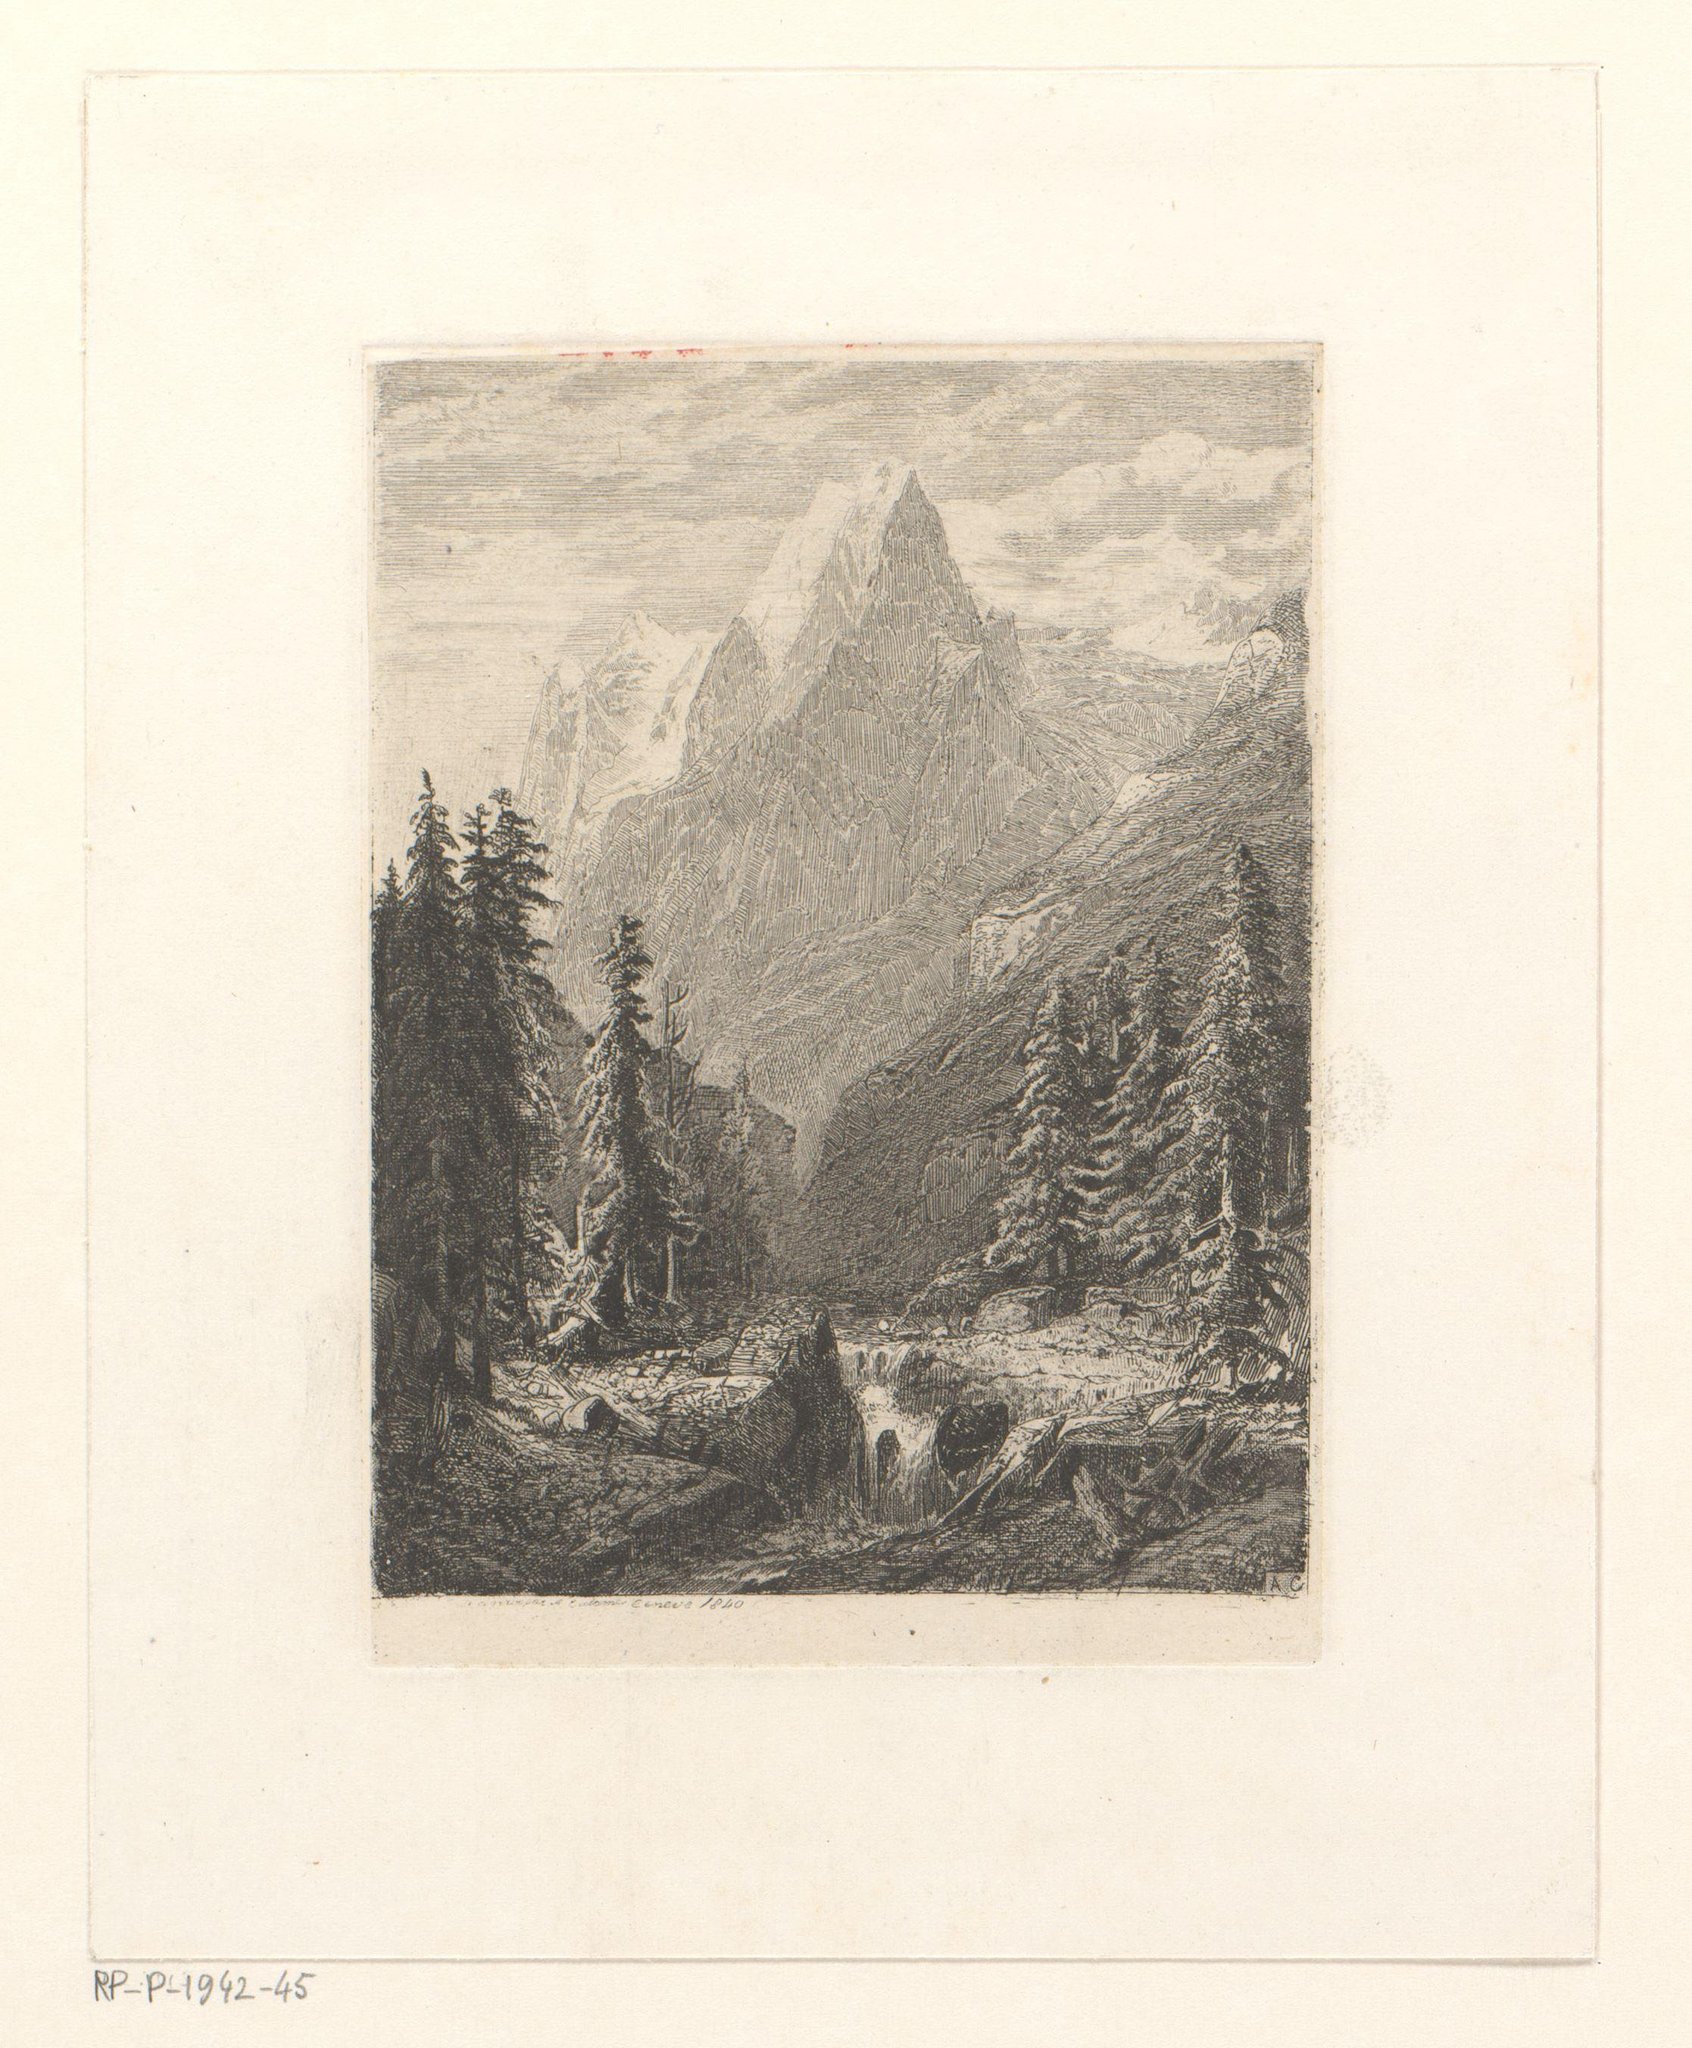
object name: print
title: Zwitsers berglandschap met dennenbomen aan een beek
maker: alexandre calame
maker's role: draughtsman, painter, print maker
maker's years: 1810-1864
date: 1840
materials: paper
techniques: etching, roulette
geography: geneva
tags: brook, trees: pine, mountains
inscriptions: collector's mark: Lugt 2760, collector's mark: Lugt 2228